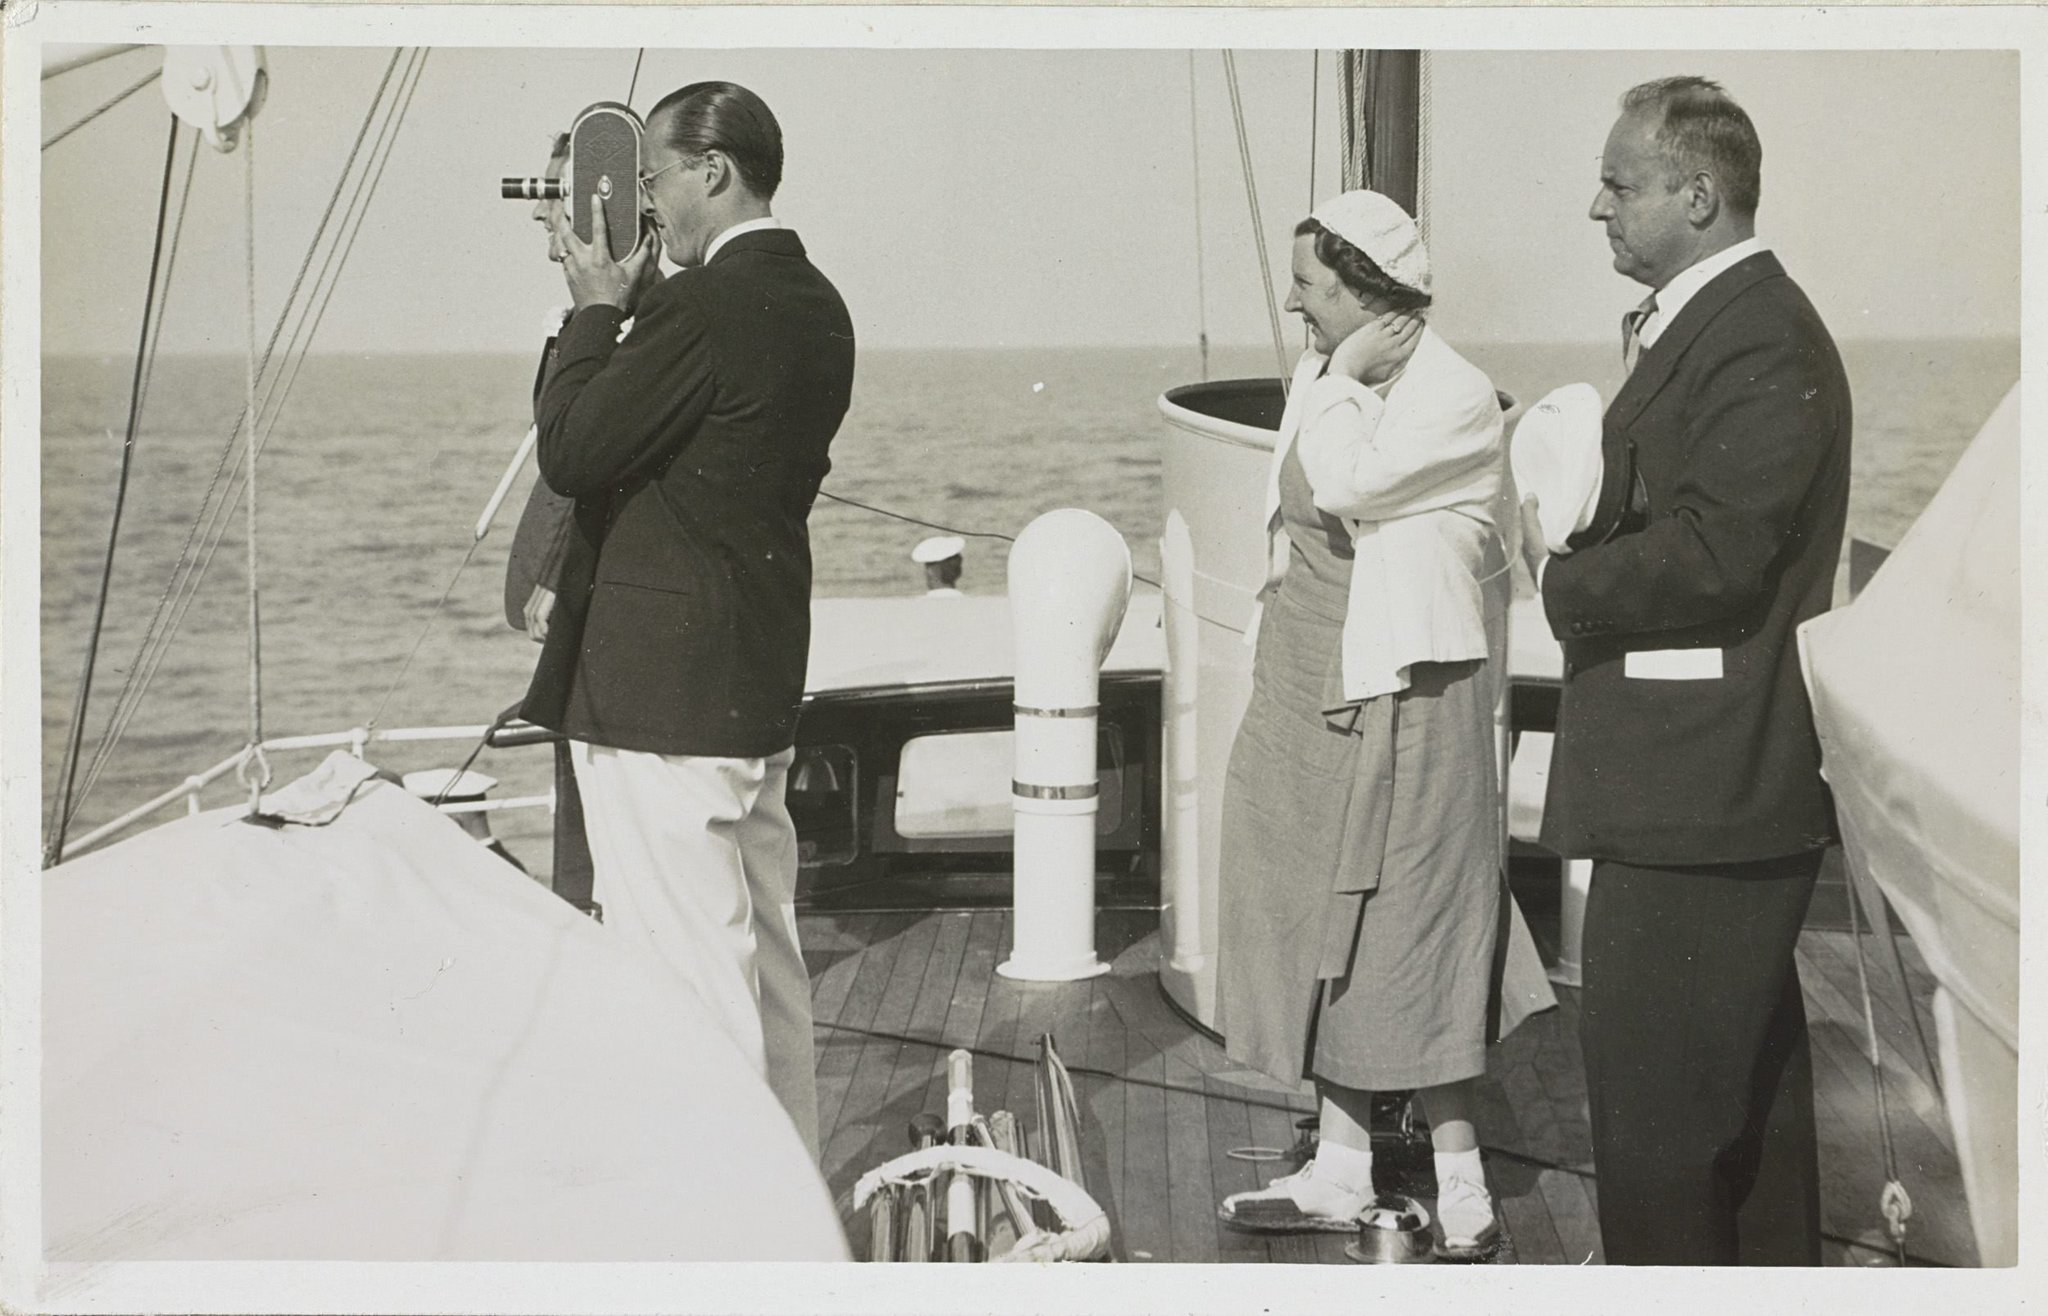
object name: photograph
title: Bezoek van Juliana, koningin der Nederlanden, en Bernhard van Lippe-Biesterfeld aan het prinsenjacht Hr. Ms. 'Piet Hein' te Muiden op 28 augustus 1937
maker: Anonymous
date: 1937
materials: photographic support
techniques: photography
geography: netherlands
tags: utrecht, bernhard (prins der nederlanden), the hague, juliana of the netherlands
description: De hier vermelde titel verwijst naar de hoogst verkregen titel van de geportretteerde, niet per se naar de titel die de geportretteerde op deze voorstelling draagt.